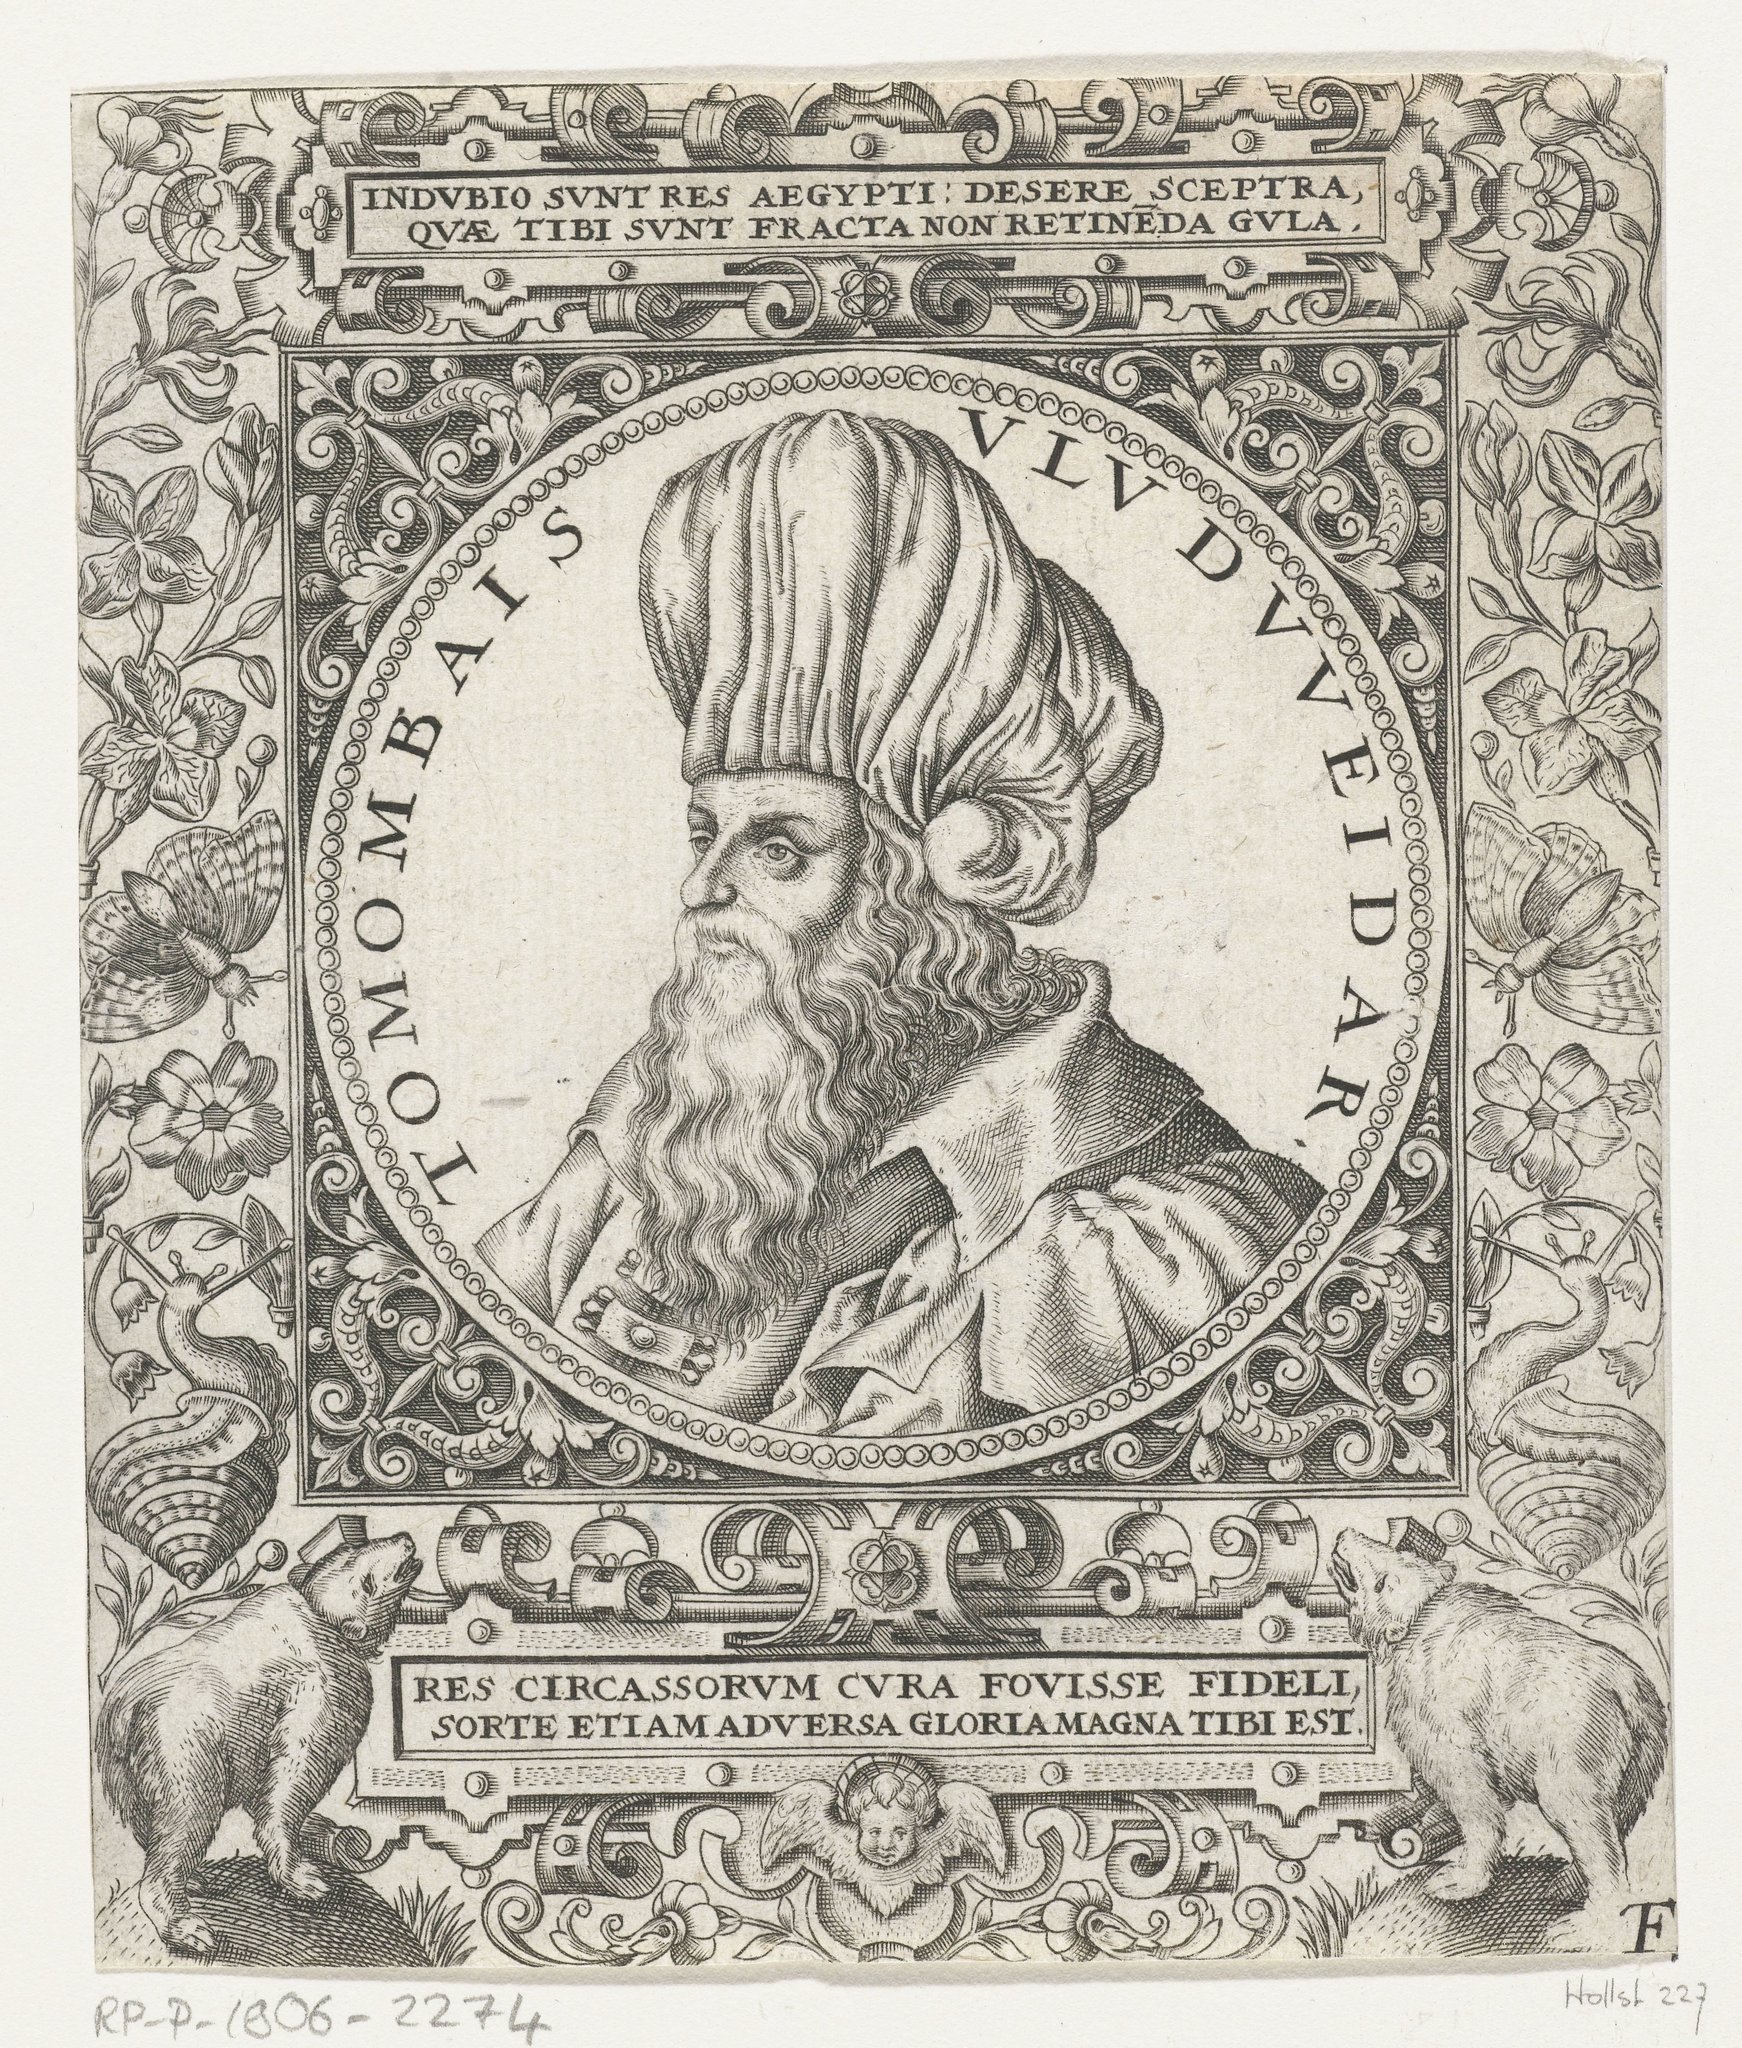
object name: print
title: Tomombais Vlv Dvveidar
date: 1596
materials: paper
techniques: engraving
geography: frankfurt am main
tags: islam, mohammedanism, ruler, sovereign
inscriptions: collector's mark: Lugt 2228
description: Afkomstig uit: J.J. Boissard, Vitae et icones svltanorvm tvrcicorum, principvm persarvm aliorumq illustrium heroum heroinarumq ab Osmane usq ad Mahometem II. Frankfurt am Main: T. de Bry, 1596.